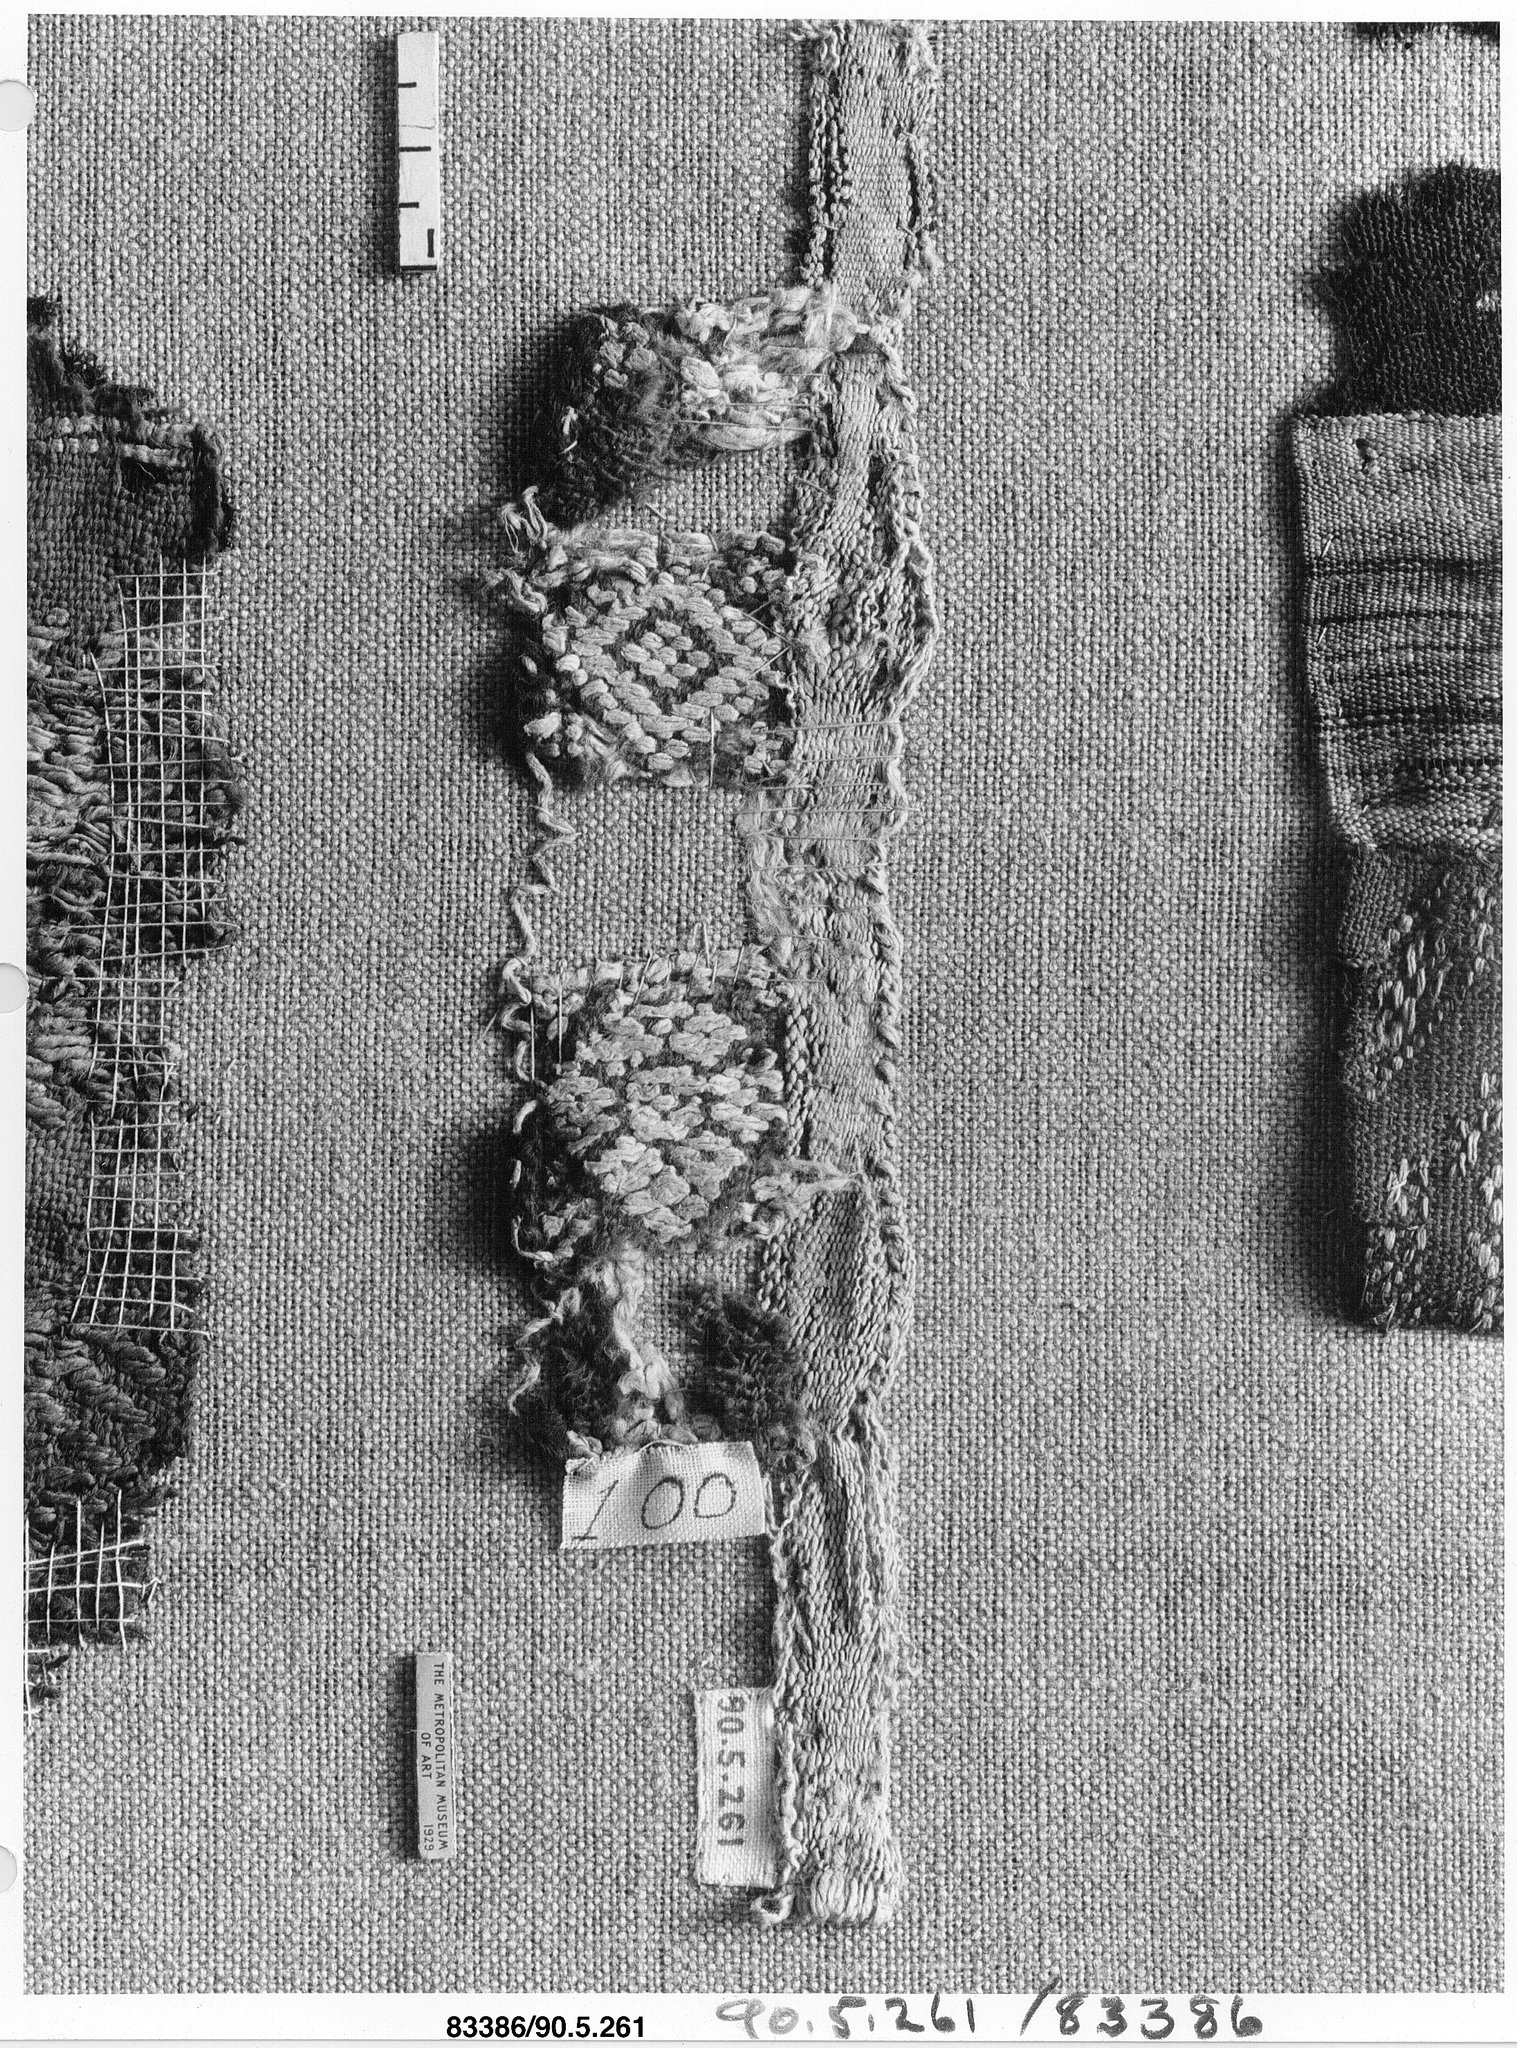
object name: textile fragment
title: Fragment of a Border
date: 501-600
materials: linen, wool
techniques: weave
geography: egypt